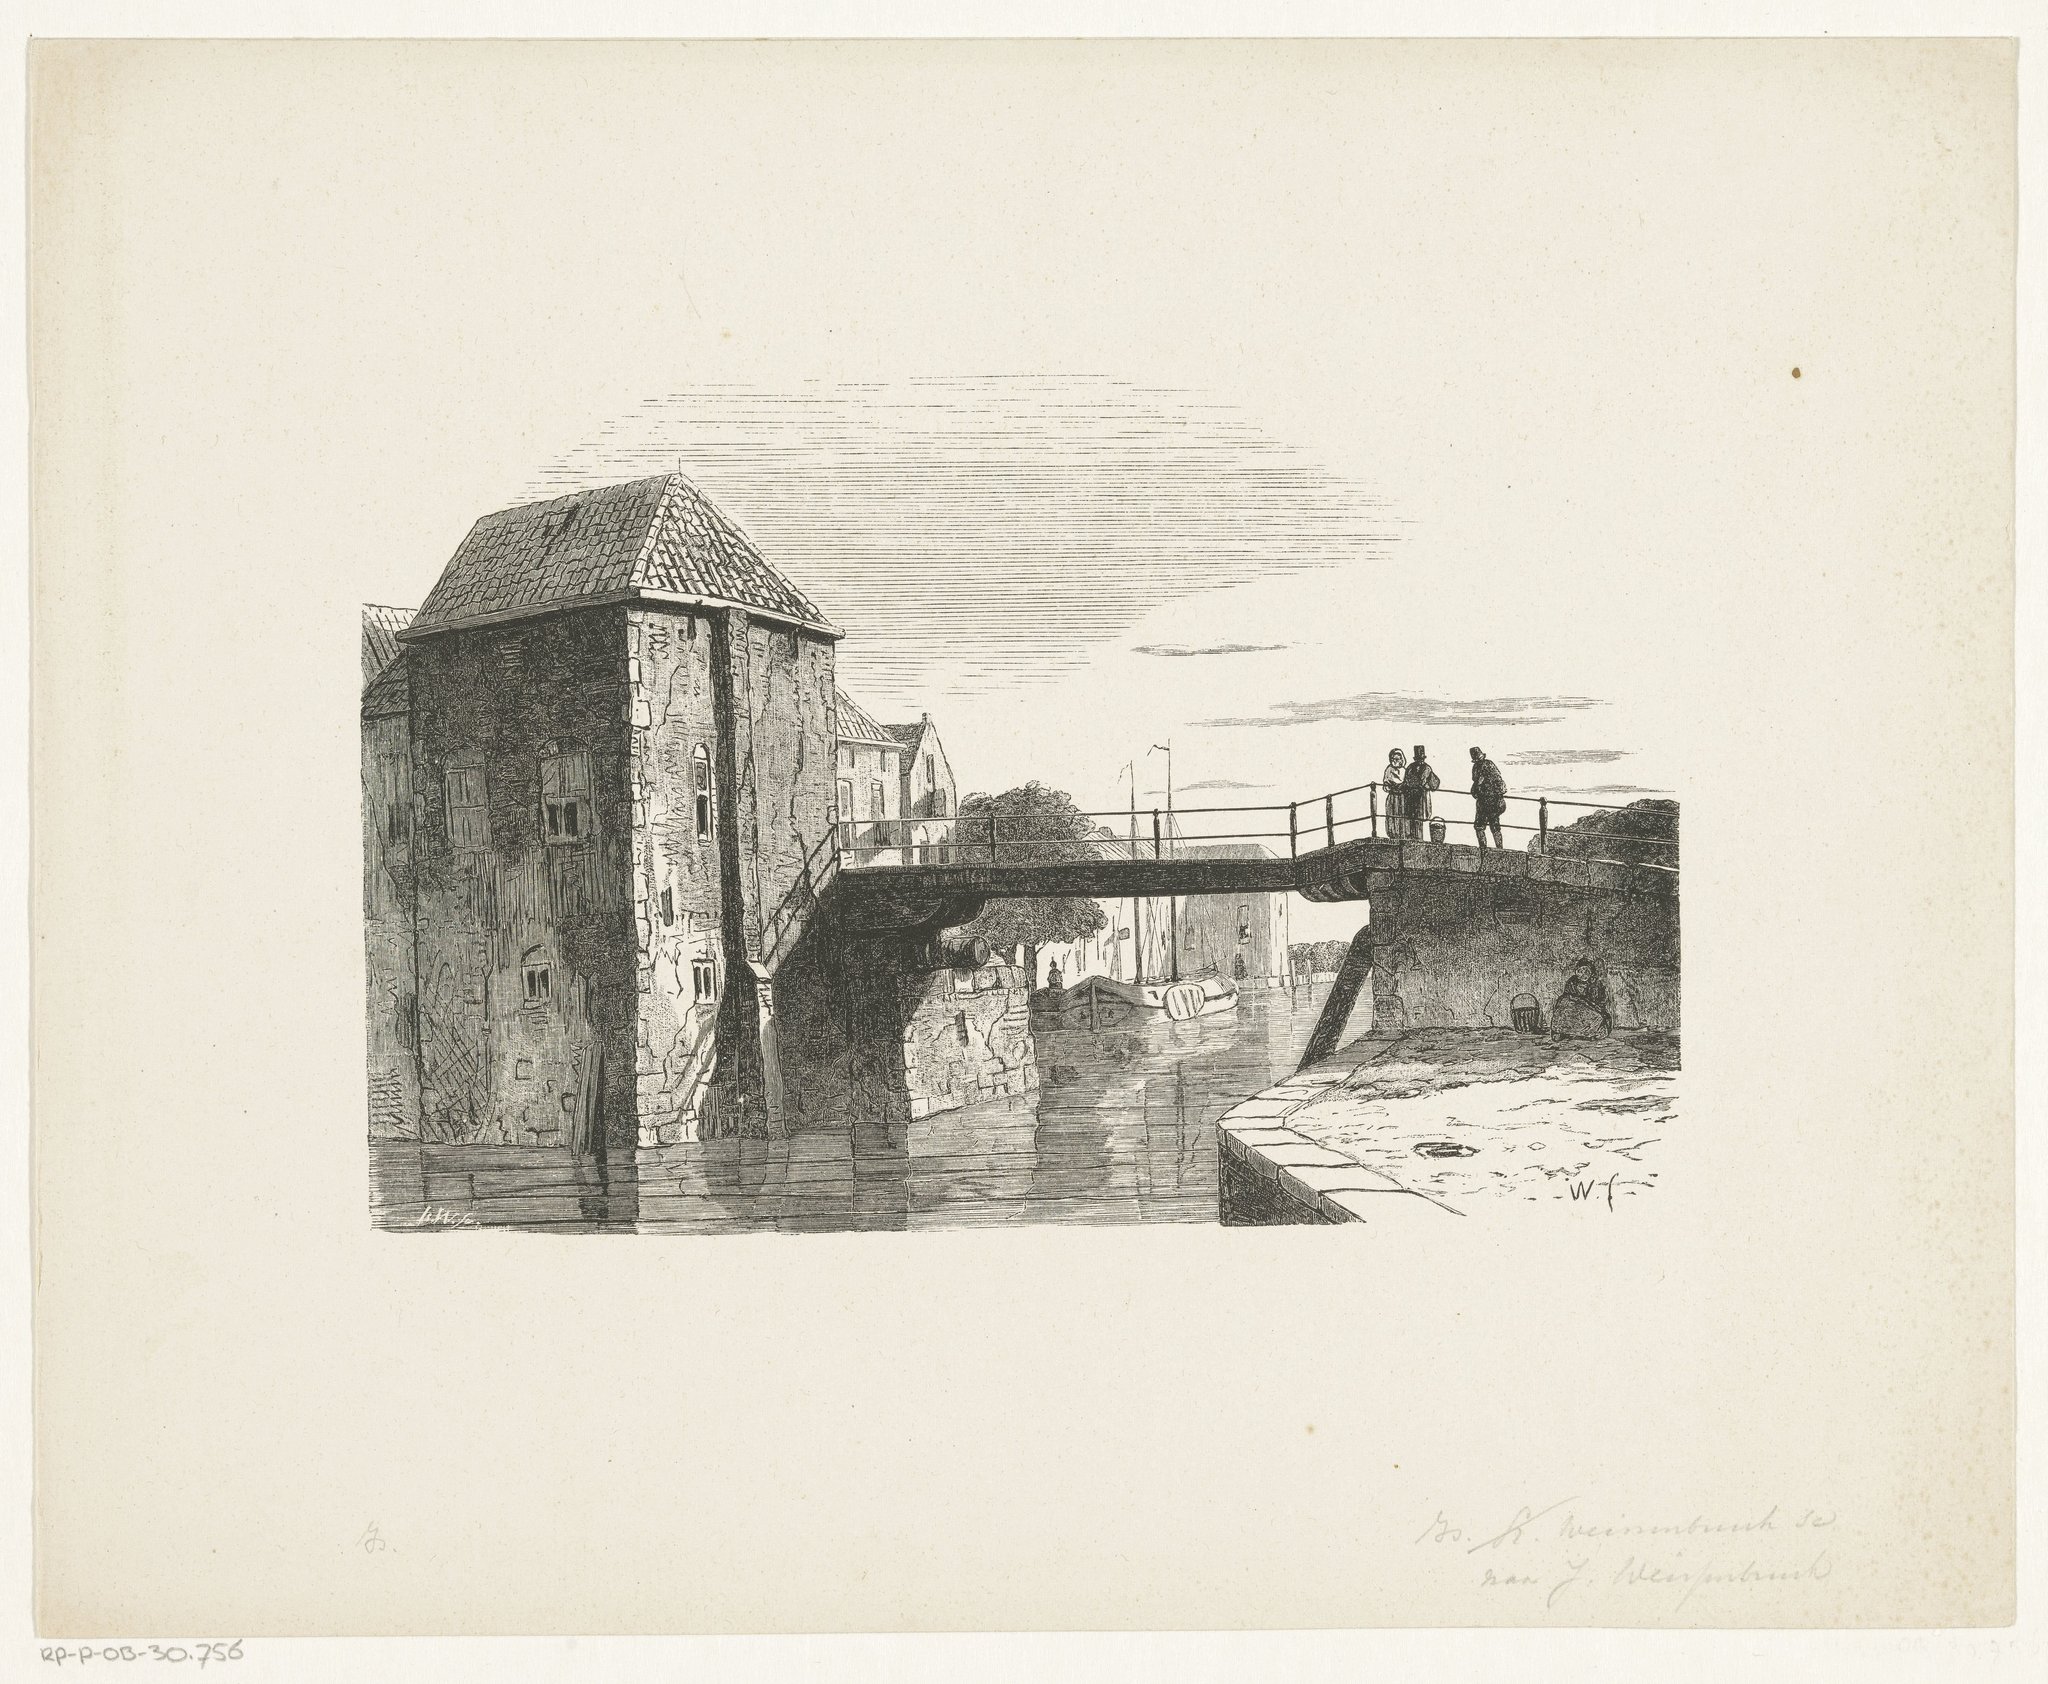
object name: print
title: Stadsgezicht met figuren op een brug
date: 1836-1912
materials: paper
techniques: engraving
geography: netherlands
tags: bridge in city across river, canal, etc. (+ city(-scape) with figures, staffage)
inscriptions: collector's mark: Lugt 2228